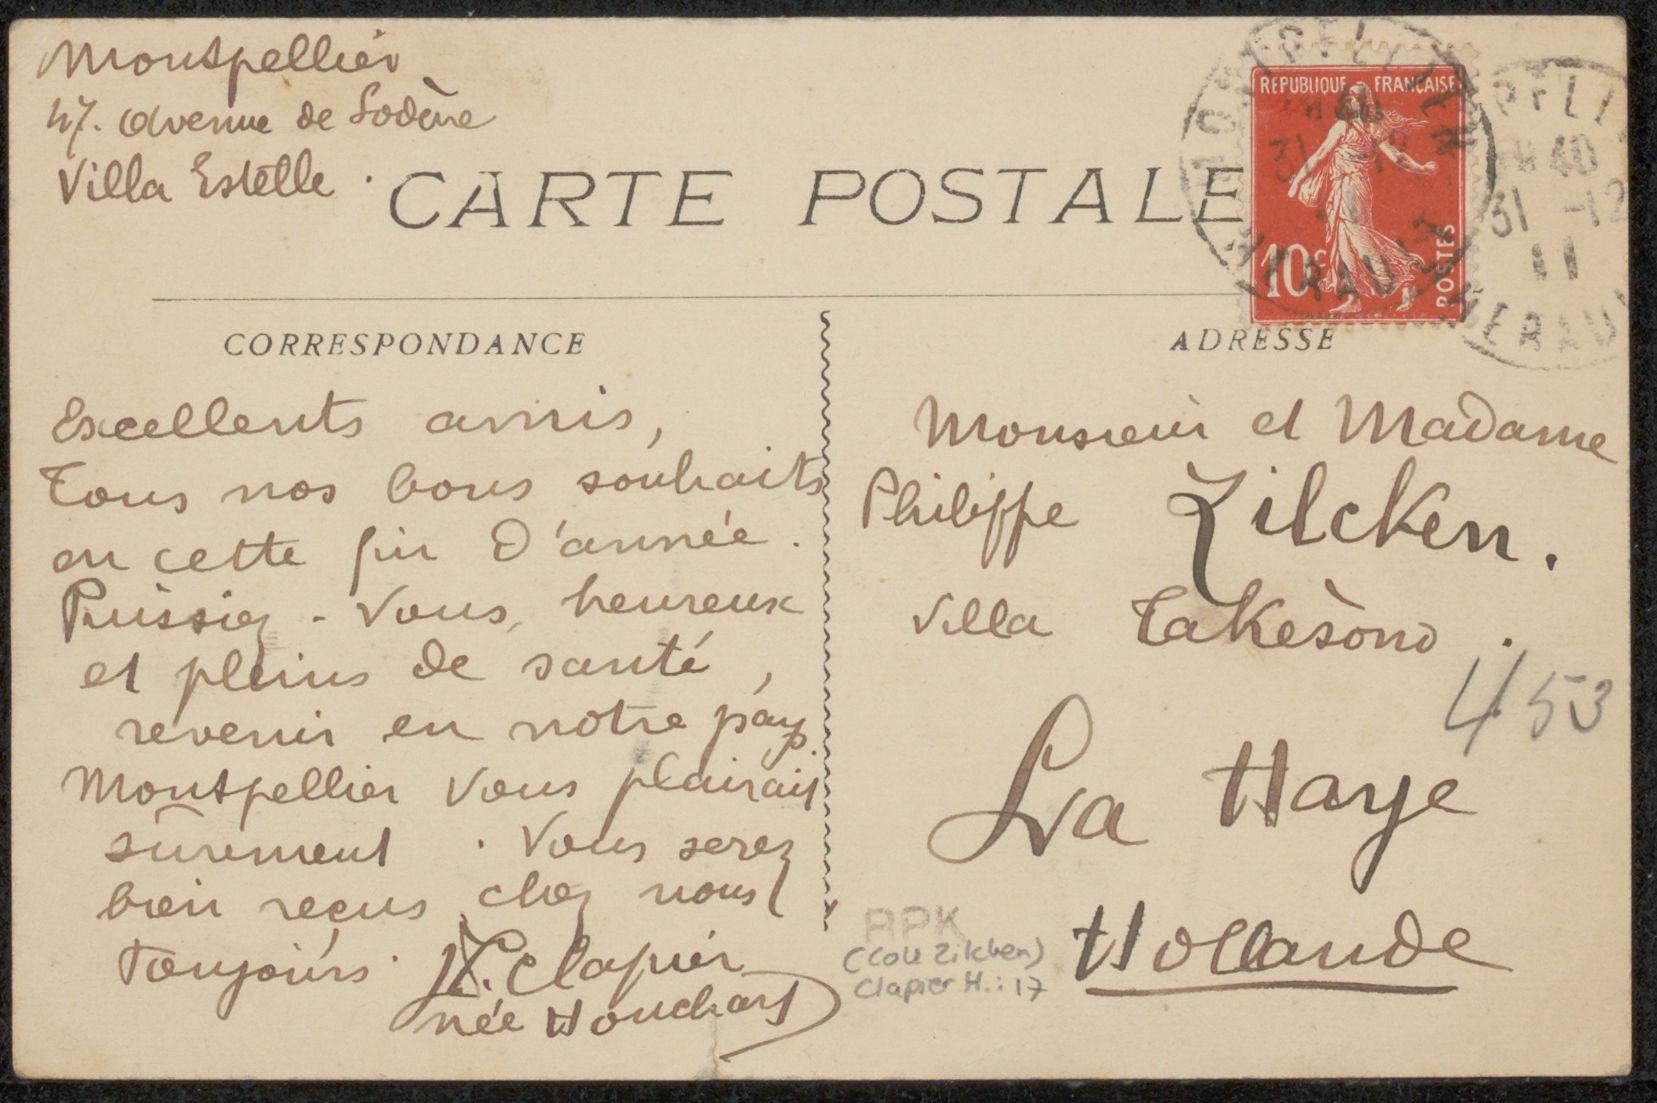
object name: ansichtkaart, prentbriefkaart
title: Prentbriefkaart aan Philip Zilcken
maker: eugénie clapier-houchart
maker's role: dichter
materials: cardboard, ink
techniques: photograph, pen, writing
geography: montpellier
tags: painter, draughtsman, philip zilcken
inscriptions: collector's mark: ‘RPK’